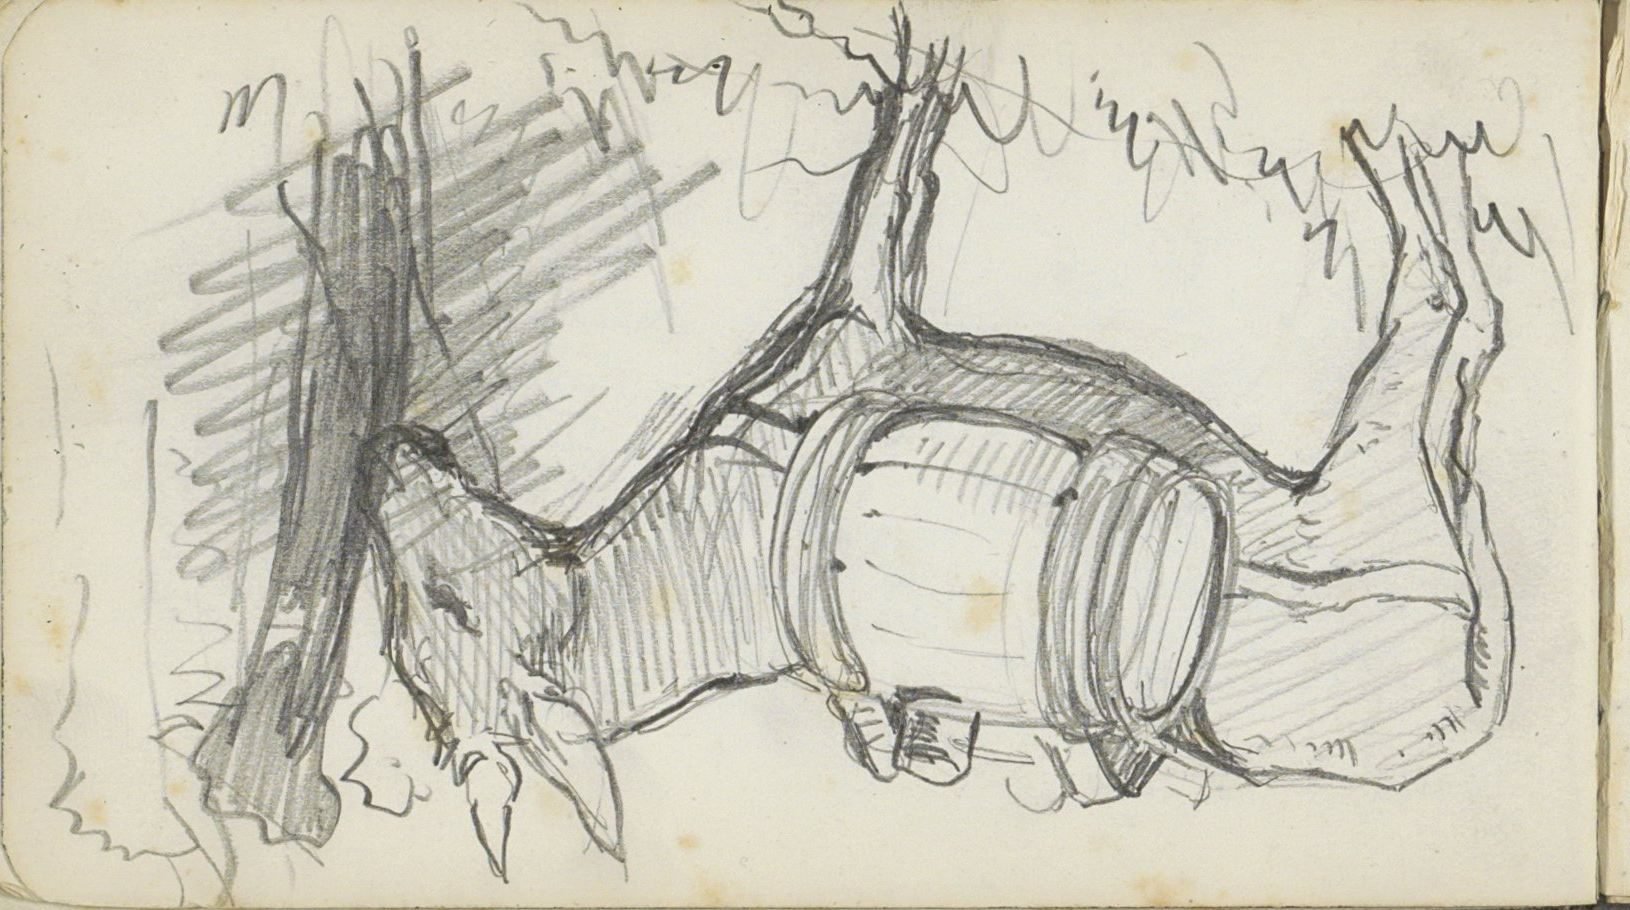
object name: sketchbook leaf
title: Gezadelde ezel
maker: geo poggenbeek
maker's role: draughtsman, painter, print maker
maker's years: 1853-1903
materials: paper, pencil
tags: ass, donkey, saddle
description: Blad 64 verso uit een schetsboek met 69 bladen.